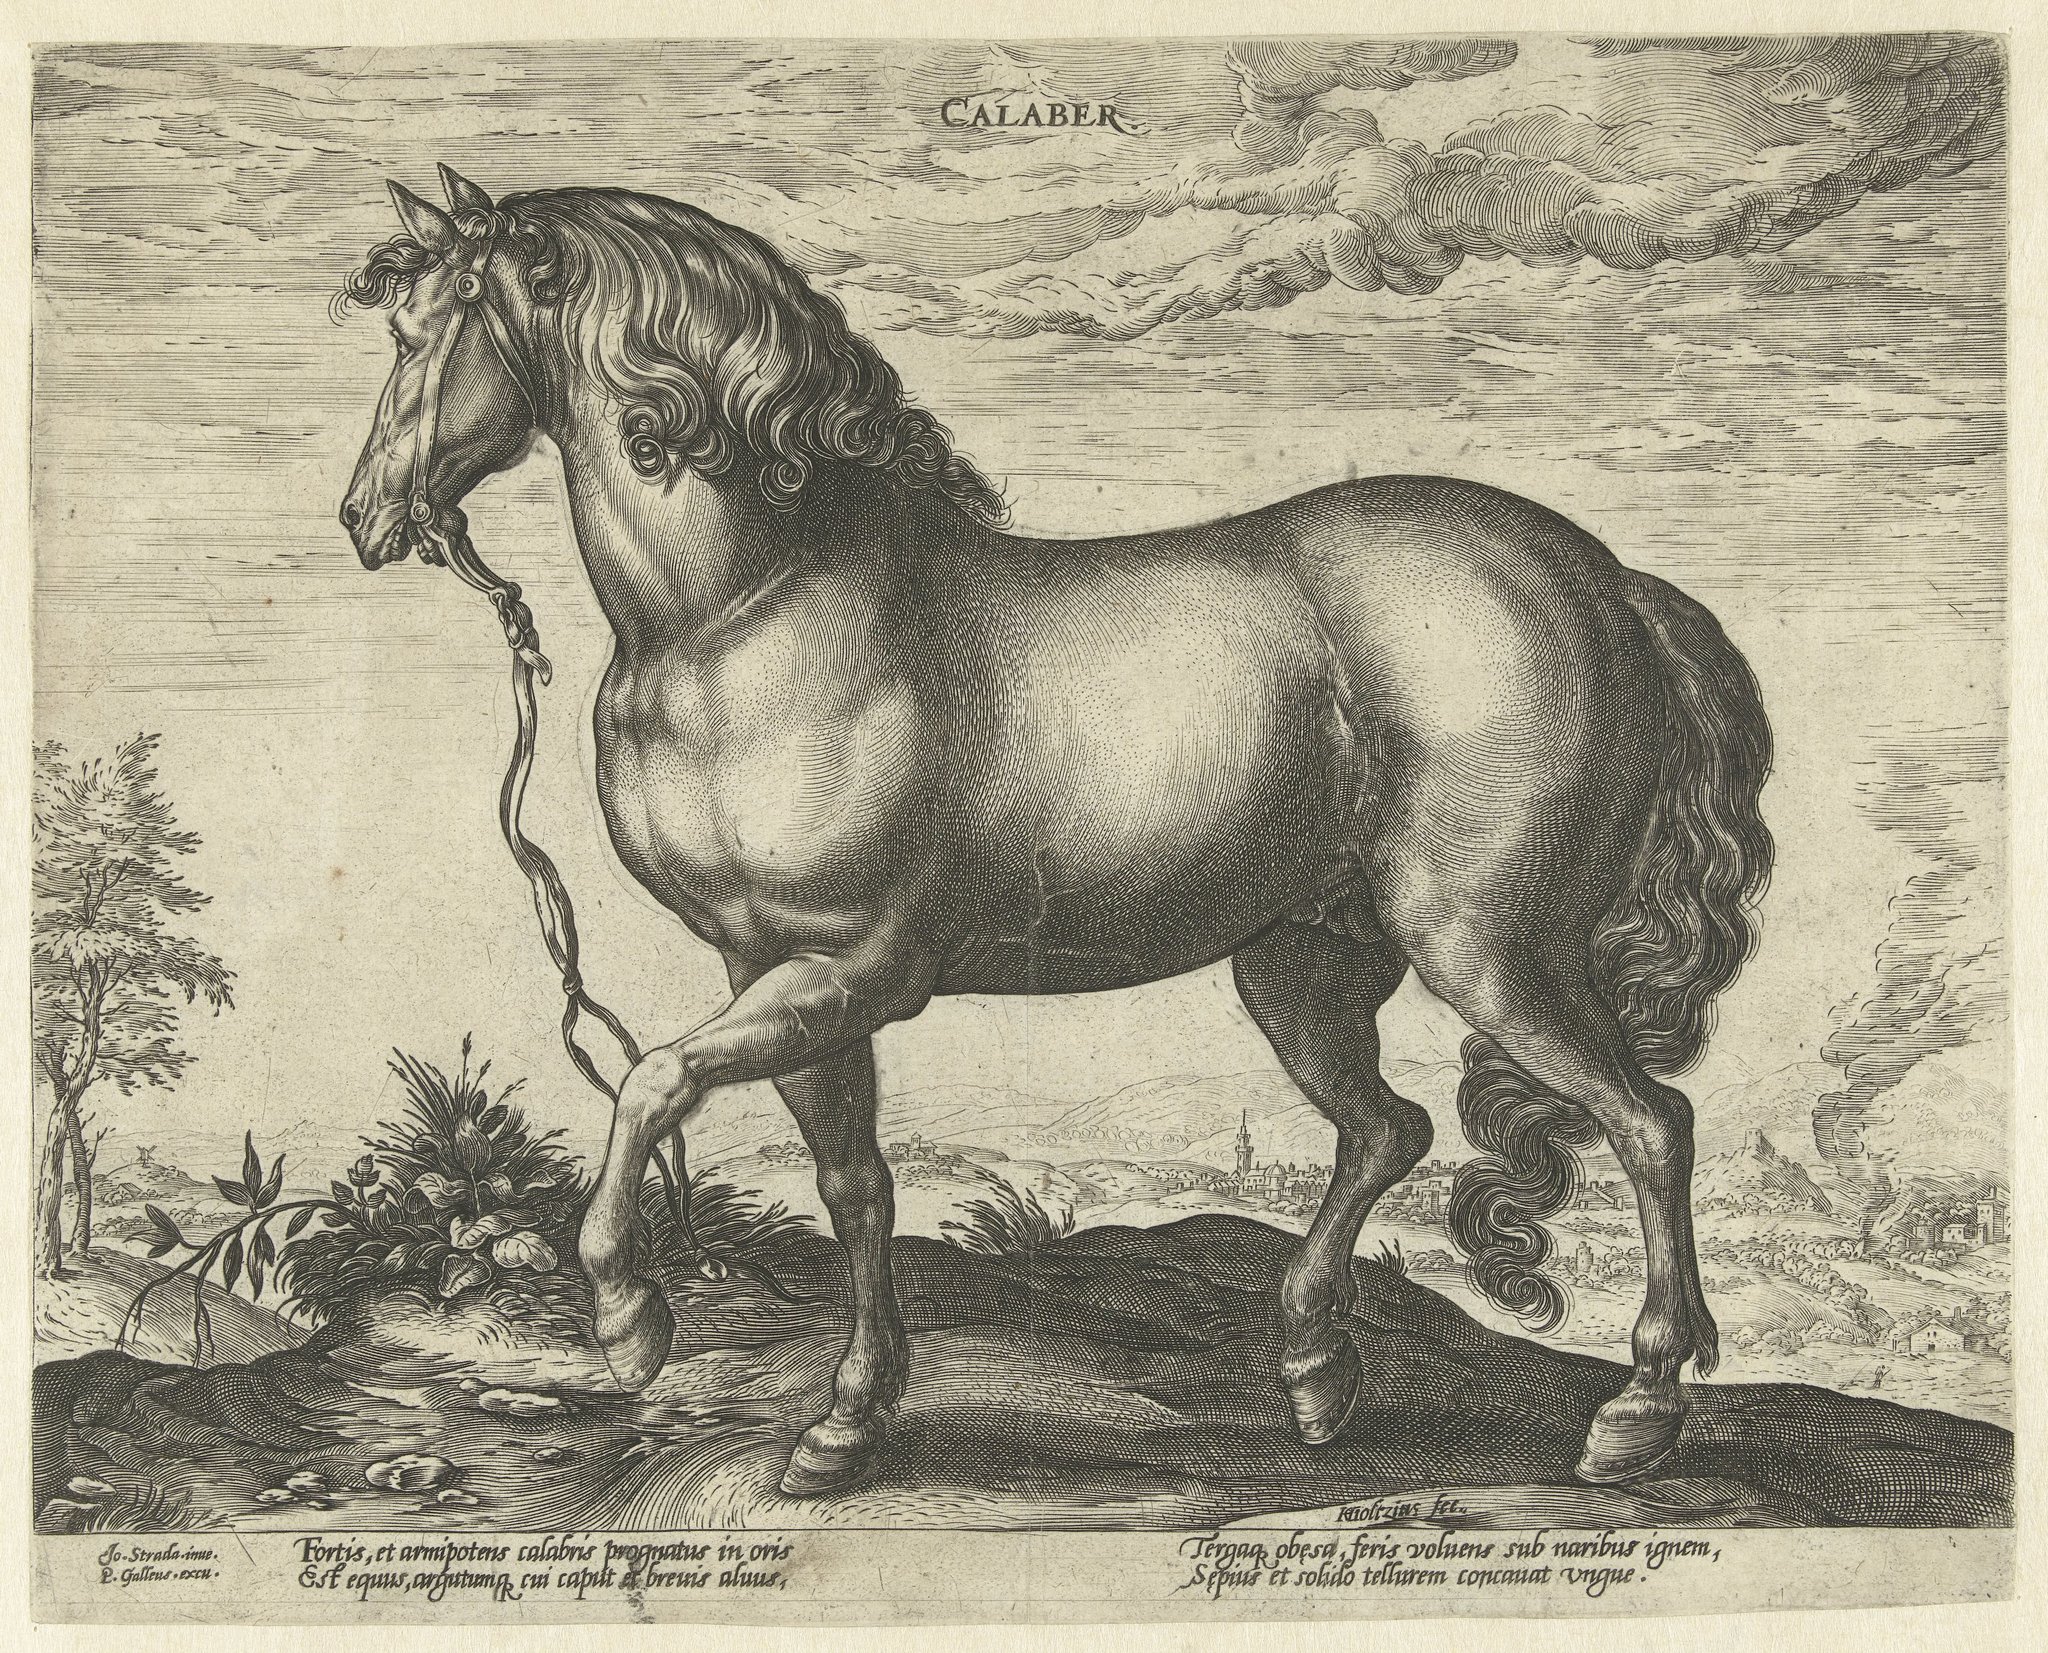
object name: print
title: Calaber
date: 1577-1581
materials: paper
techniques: engraving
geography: antwerp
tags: horse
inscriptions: collector's mark: Lugt 2228a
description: Lopend paard. Op de achtergrond een stad in een bergachtig landschap. Onder de voorstelling vier regels Latijn. Deze prent is onderdeel van een serie van veertig prenten van verschillende soorten paarden.